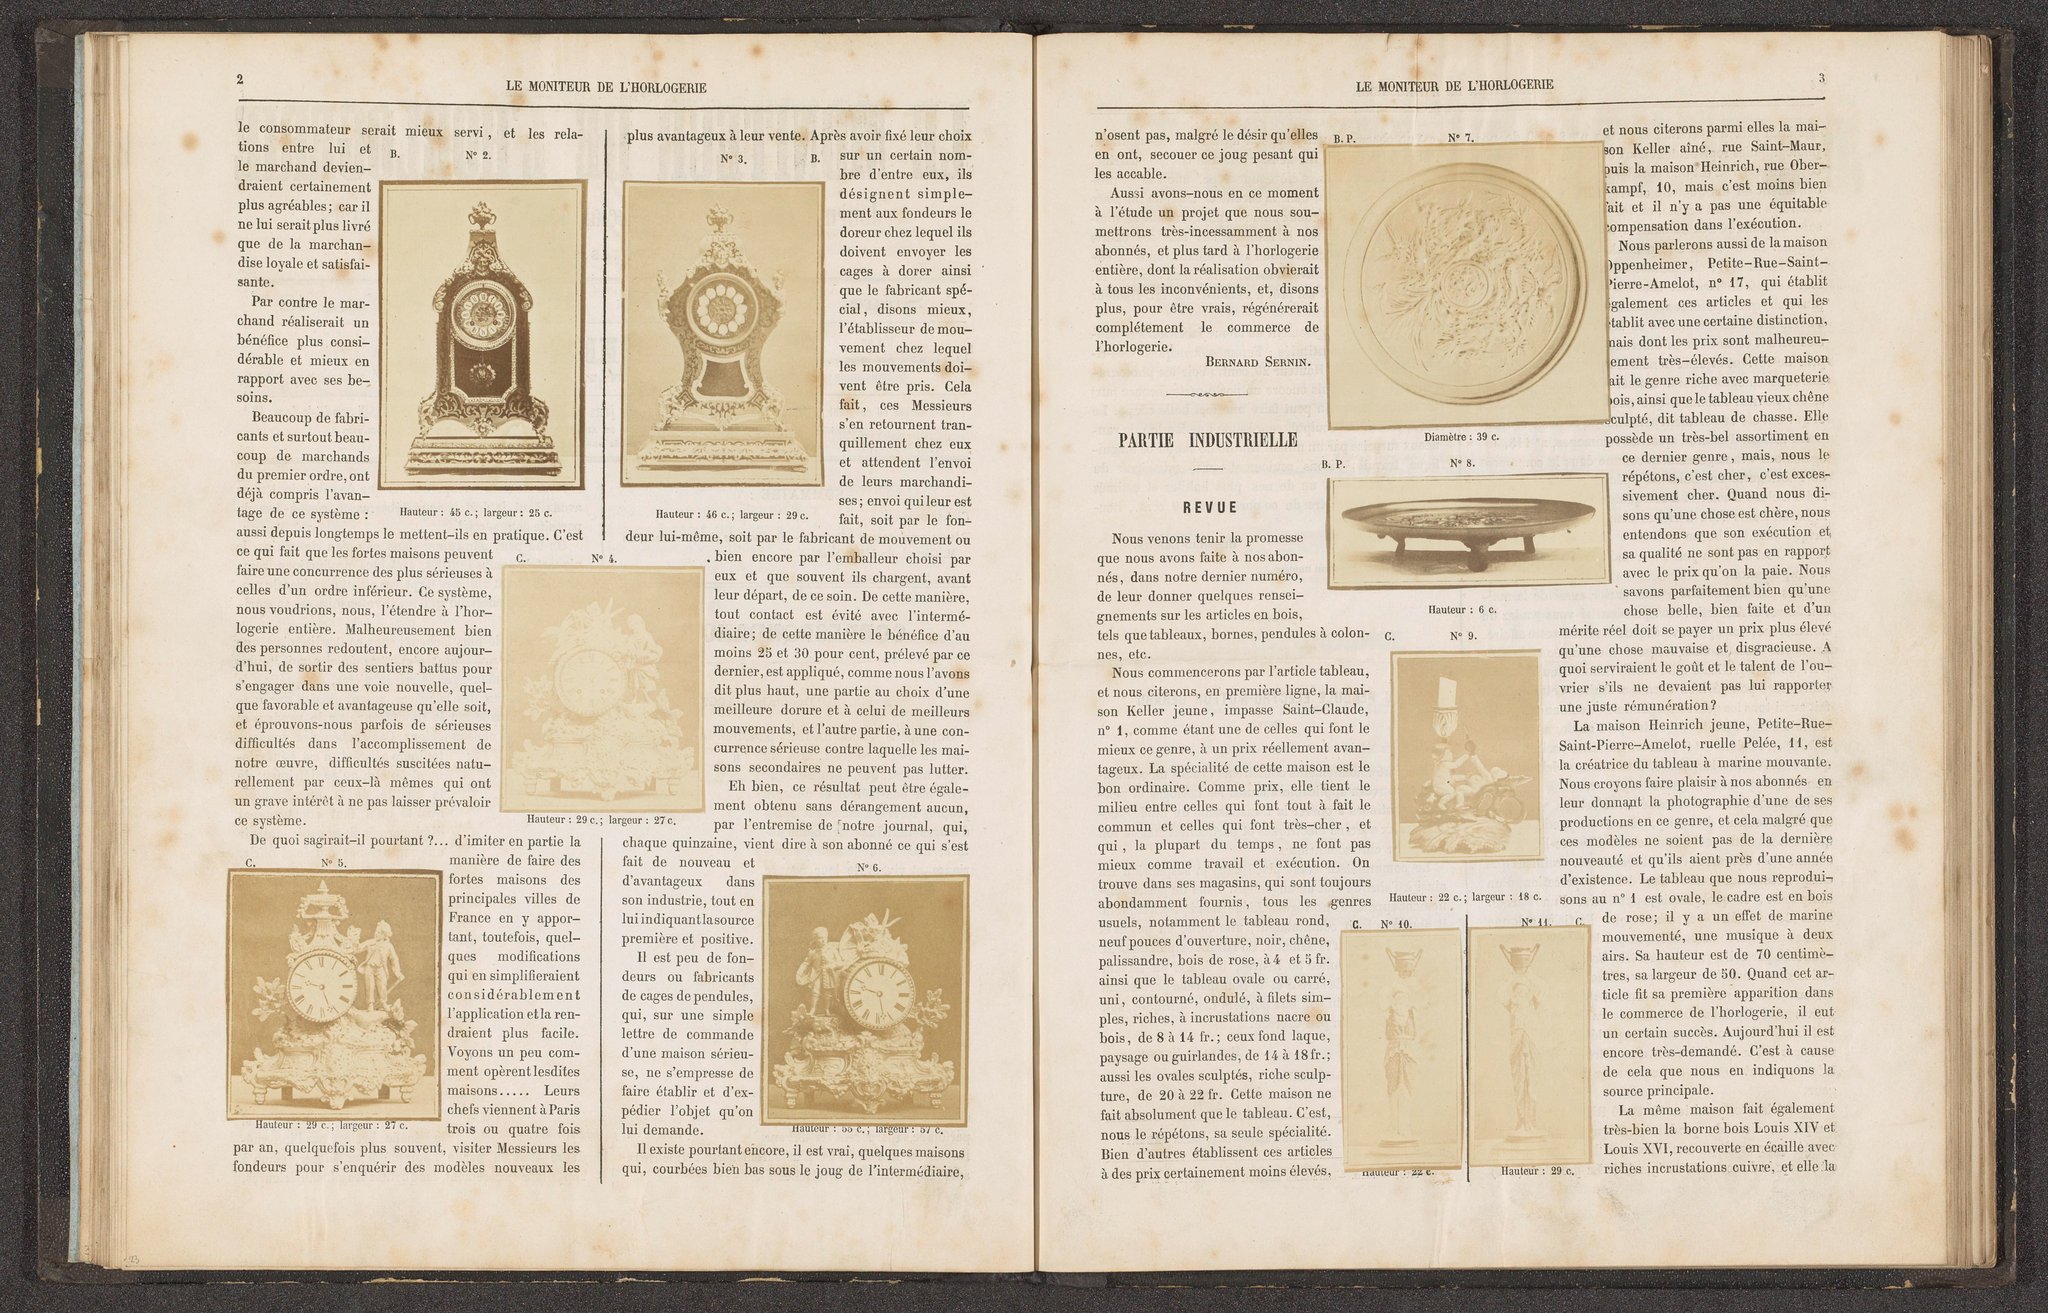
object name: page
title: Vijf klokken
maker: Anonymous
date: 1857-1867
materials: photographic support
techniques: albumen print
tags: clock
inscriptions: number: ‘No 2. No 3. No 4. No 5. No 6.’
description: Foto's op pagina 2 van nummer 7 uit 1867.